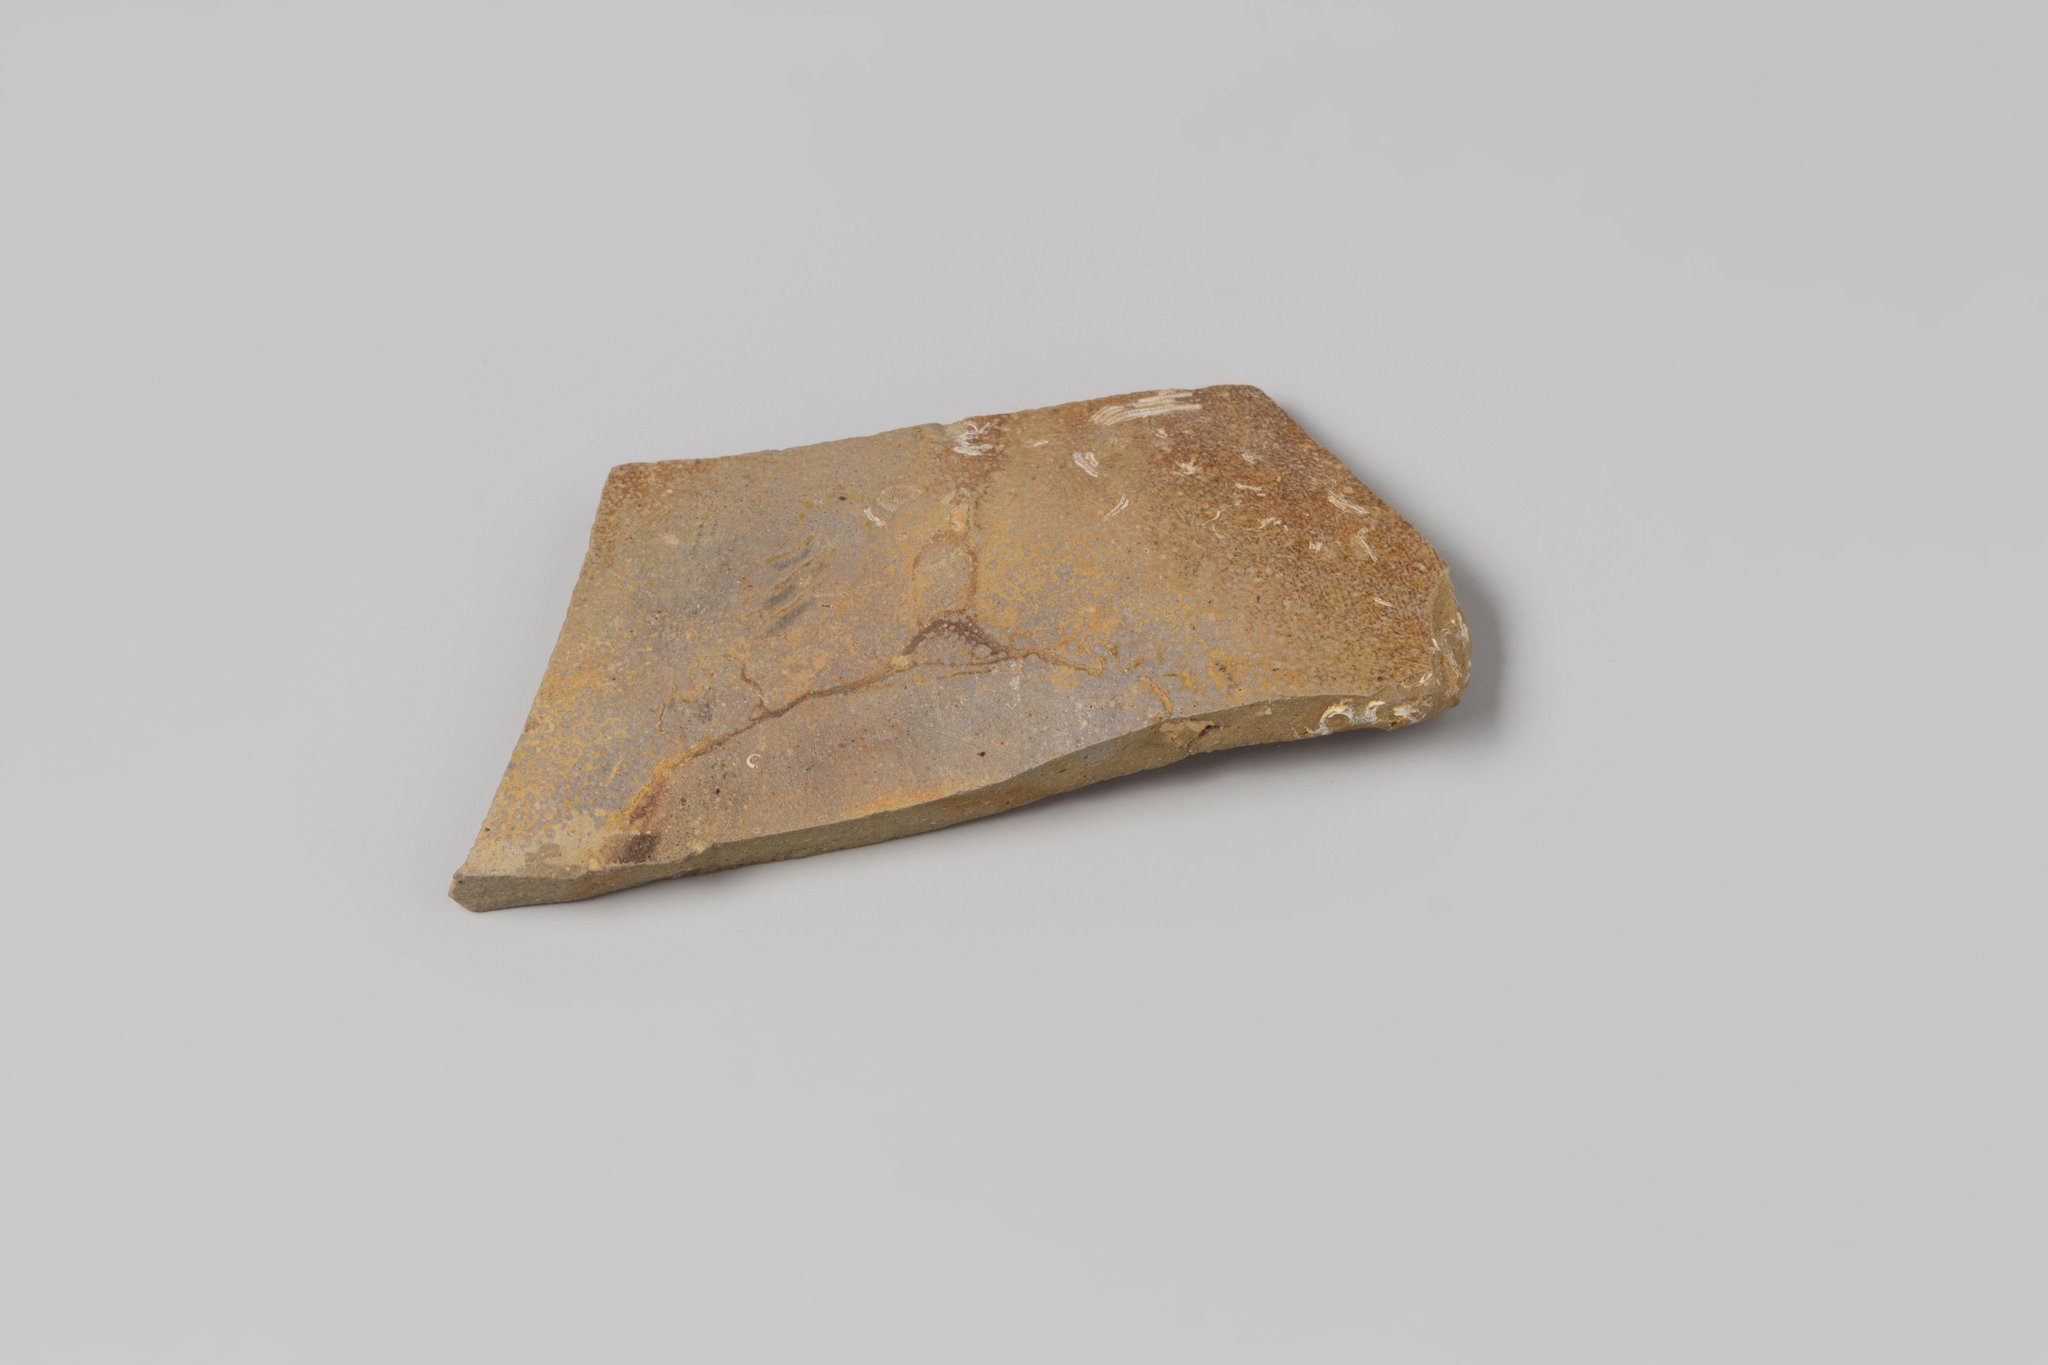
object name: ewer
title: Scherf van een kan uit het wrak van de Oost-Indiëvaarder Hollandia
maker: Anonymous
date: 1700-1743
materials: stoneware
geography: cologne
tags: verenigde oostindische compagnie, hollandia (schip), annet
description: Stoneware, Rhenish, Frechen-ware, jug; fragm of body.